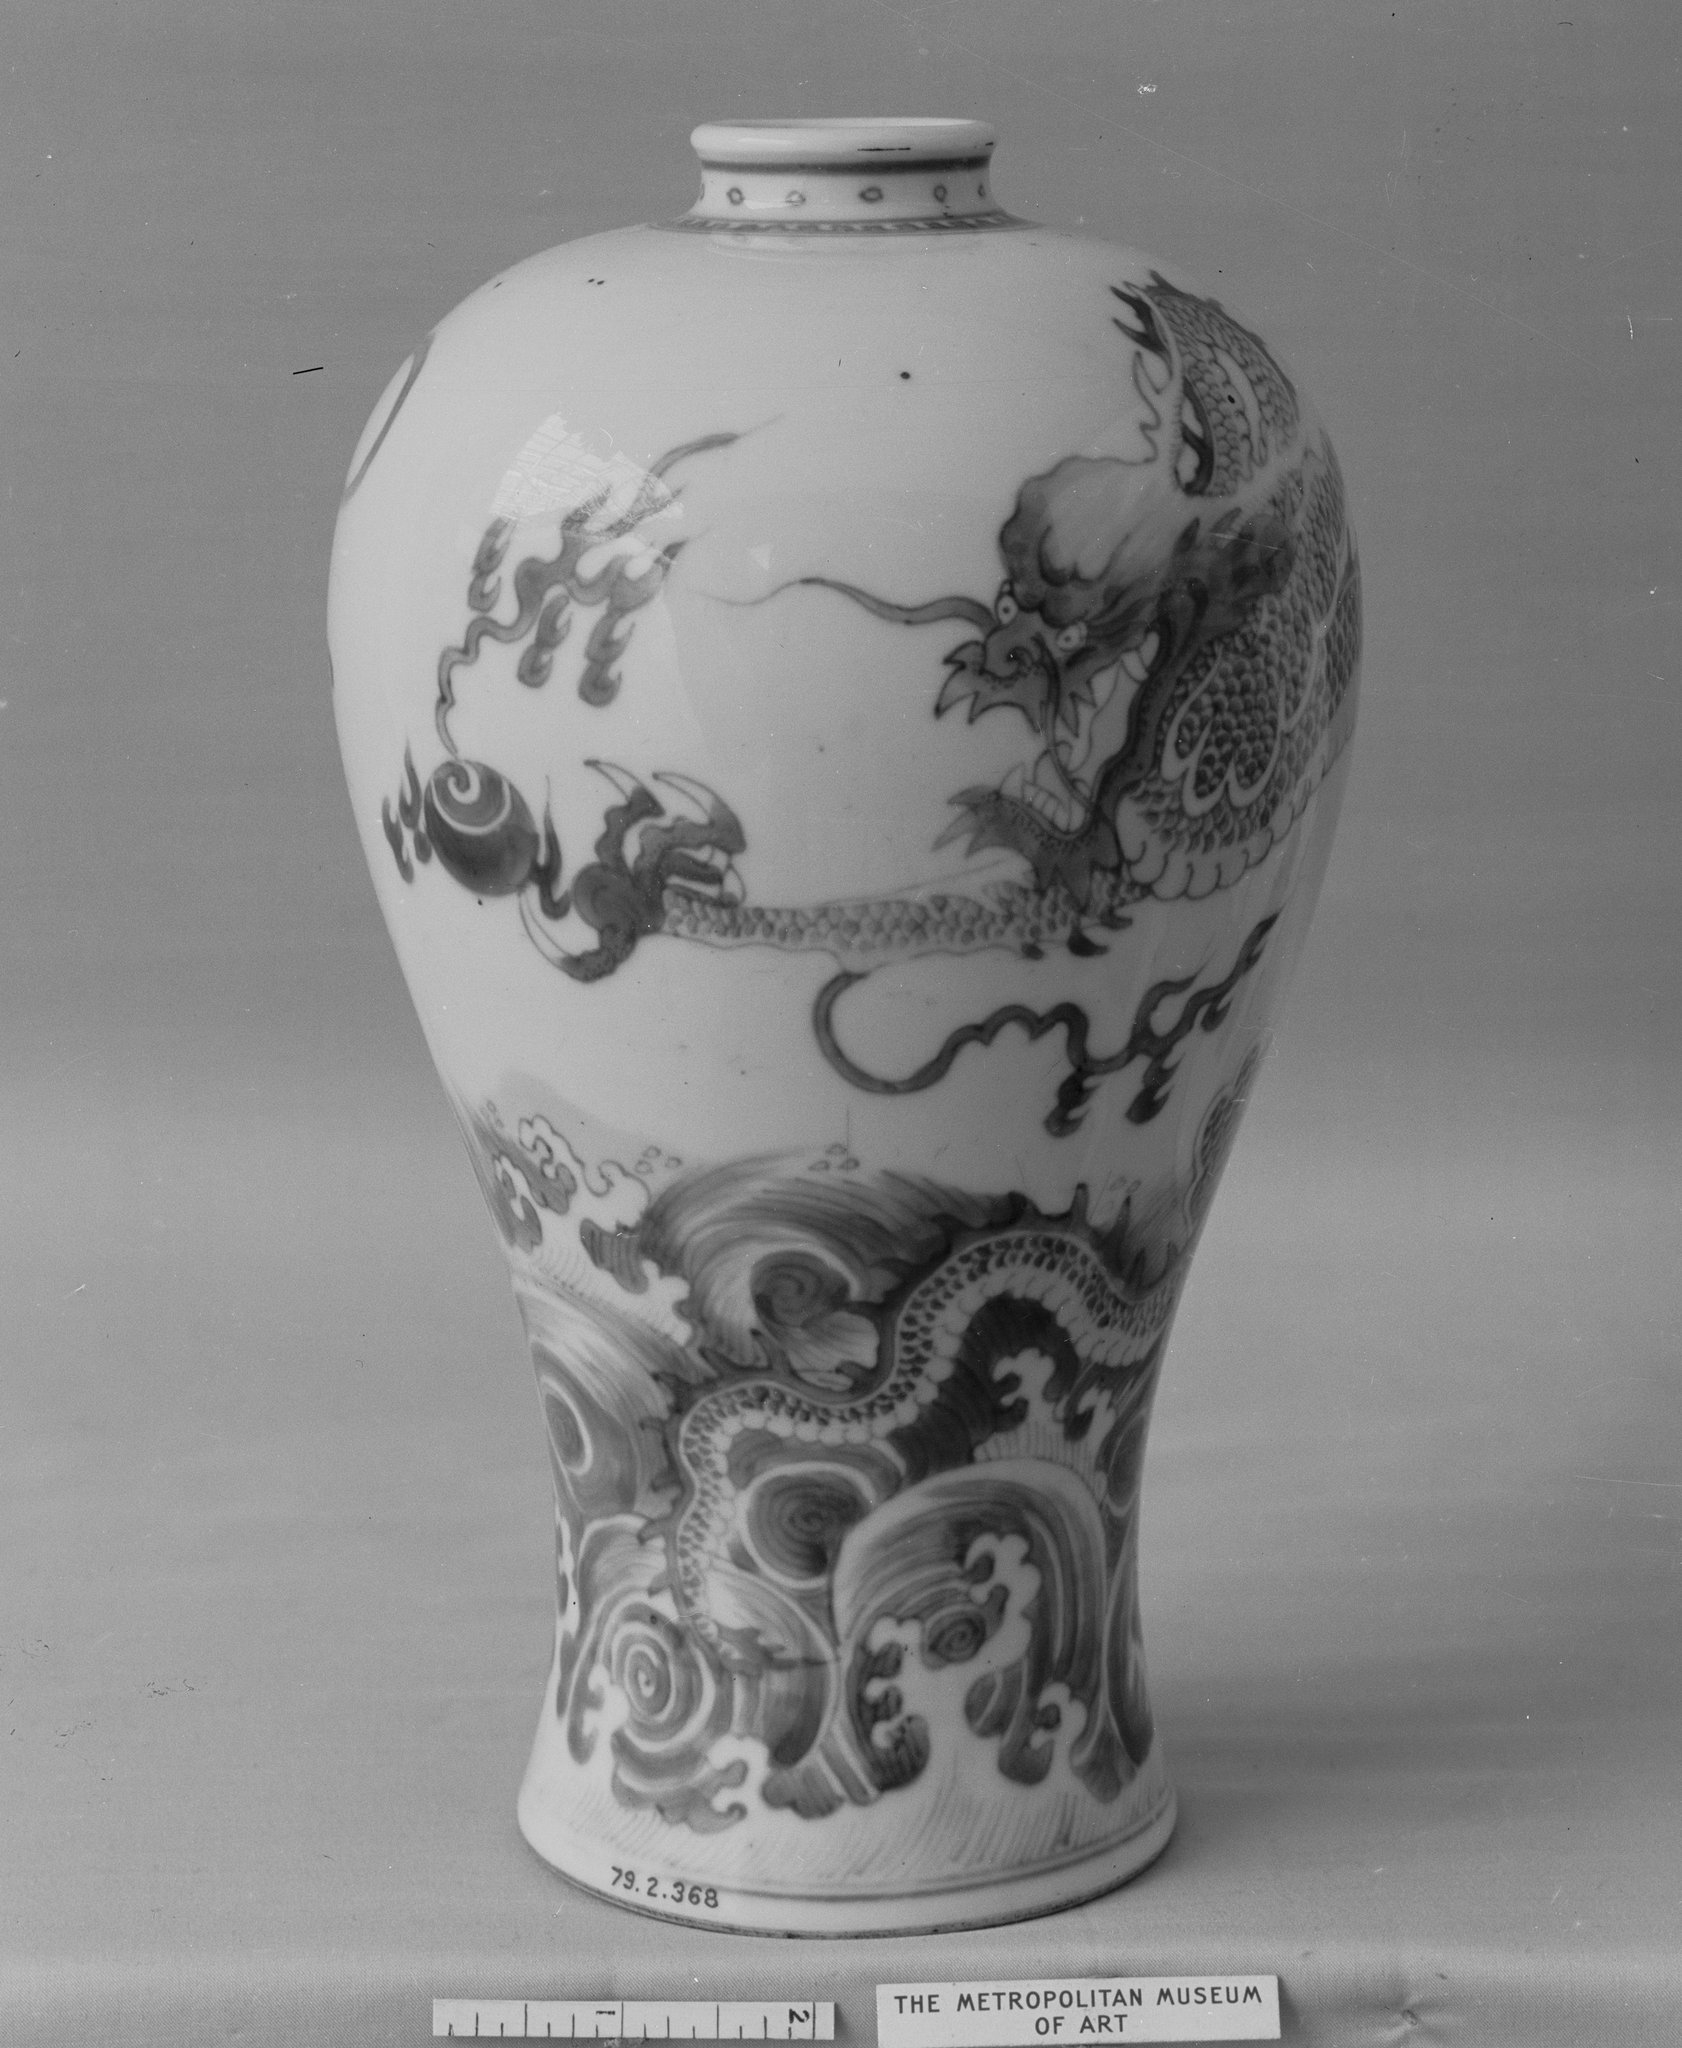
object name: vase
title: Meiping vase with dragon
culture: chinese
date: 1701-1800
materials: cobalt, porcelain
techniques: painting, underglaze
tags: dragons